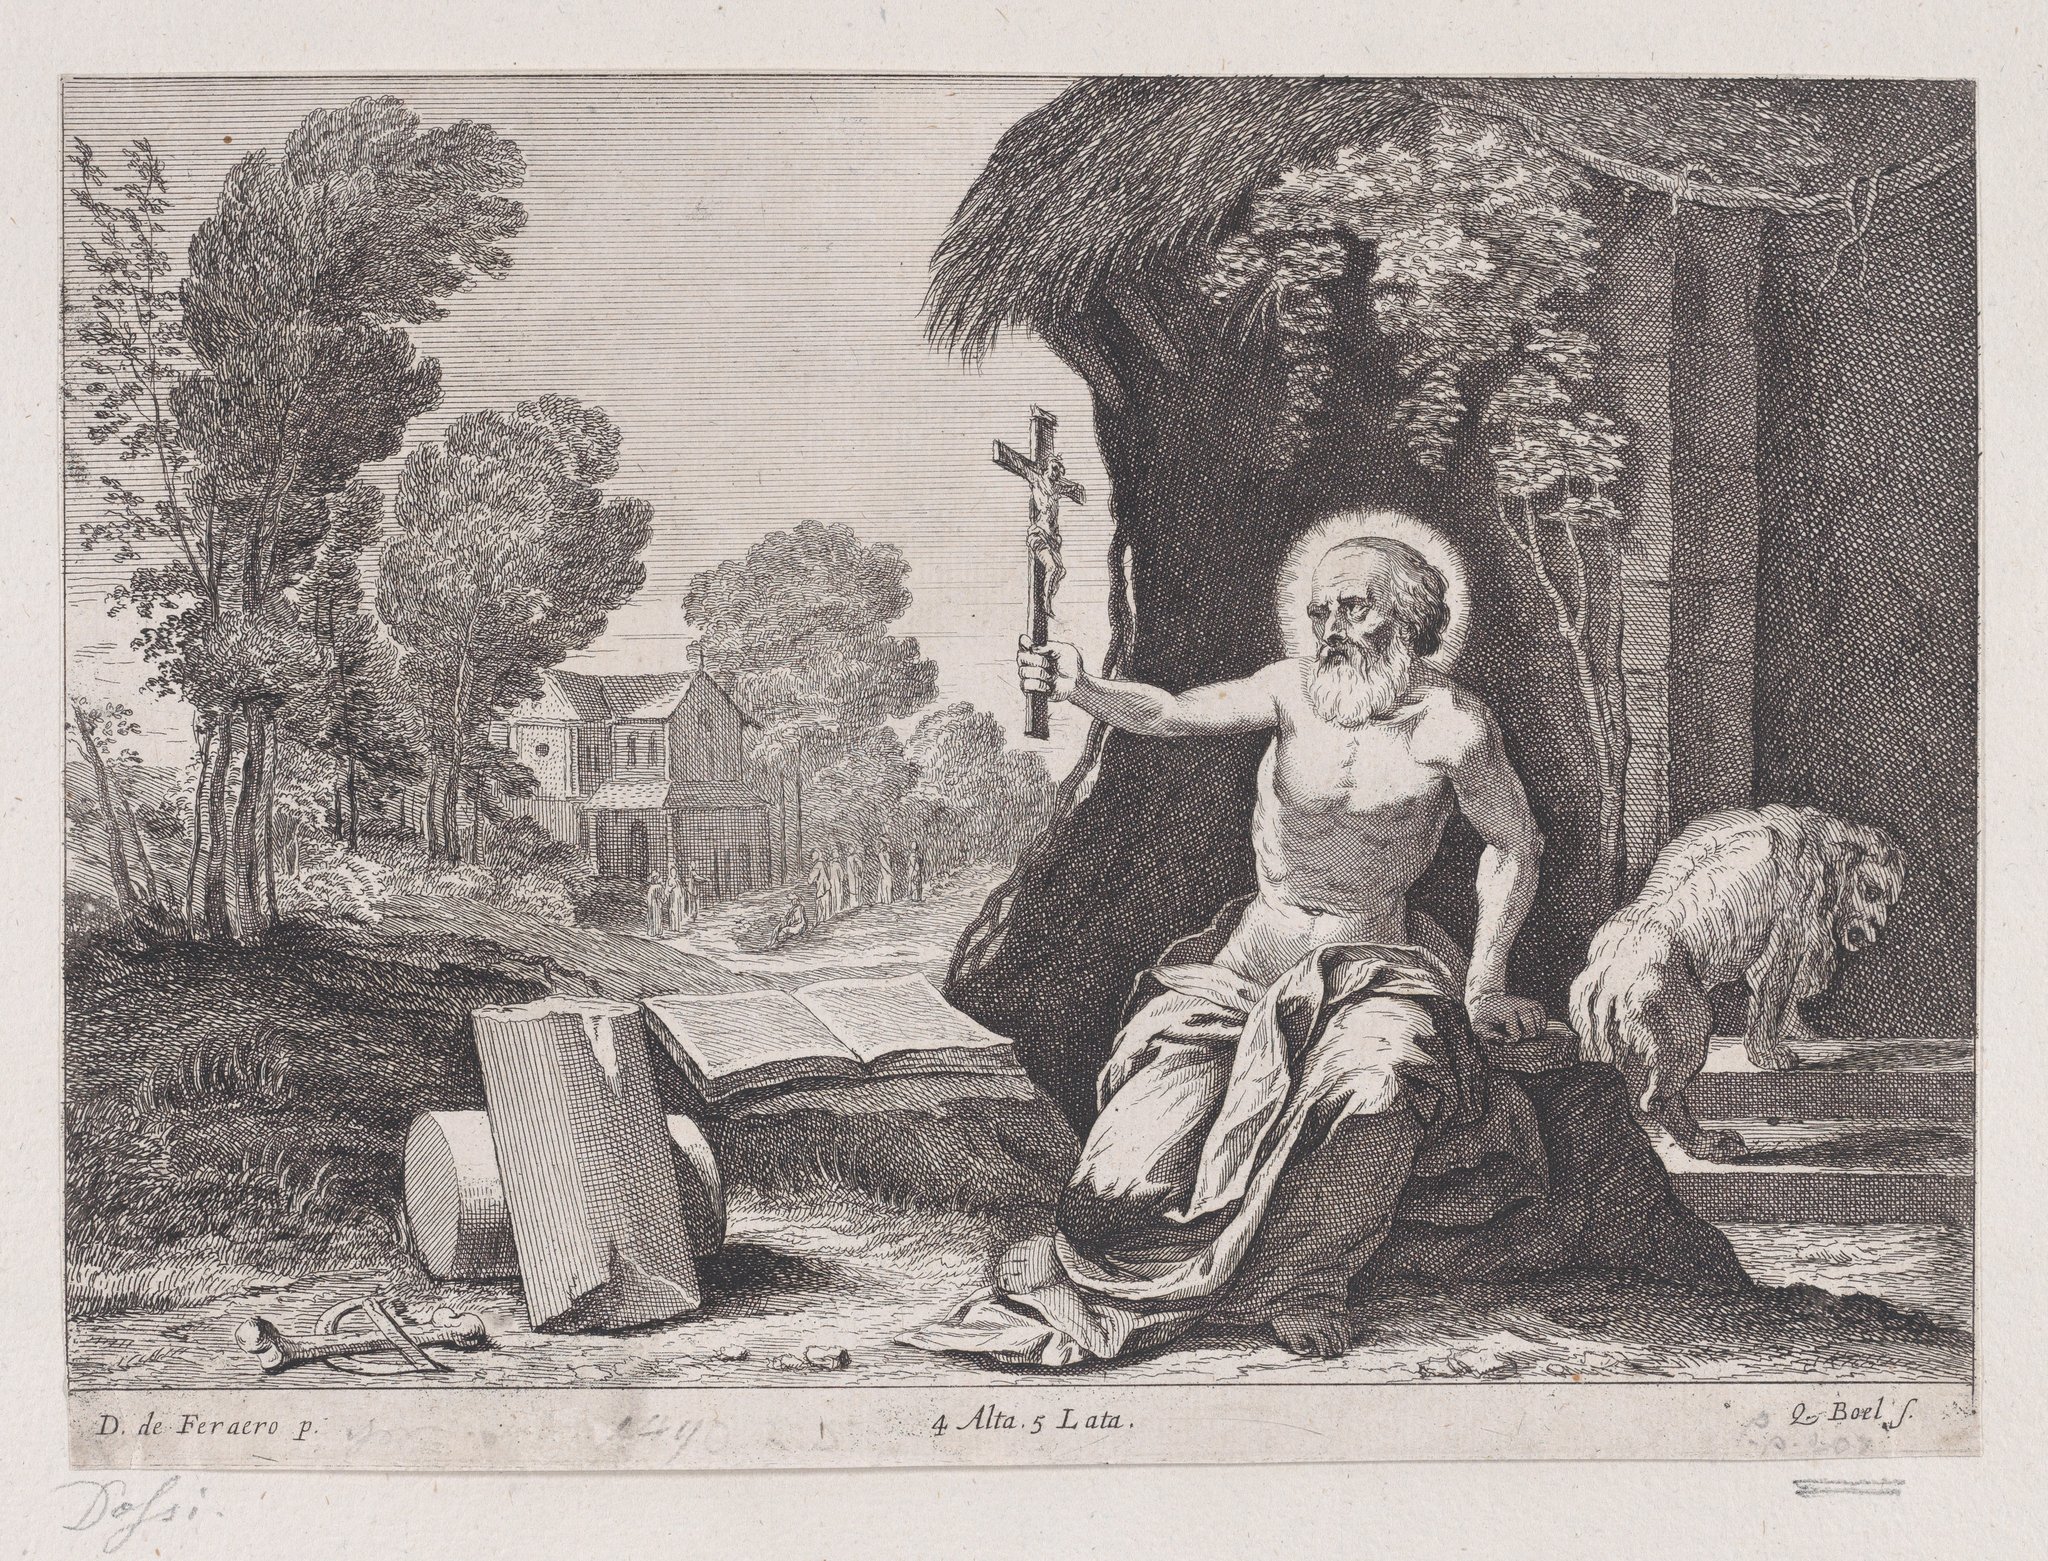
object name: print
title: Saint Jerome holding a crucifix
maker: coryn boel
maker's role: artist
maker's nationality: dutch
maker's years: 1617-1668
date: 1656-1660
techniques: etching